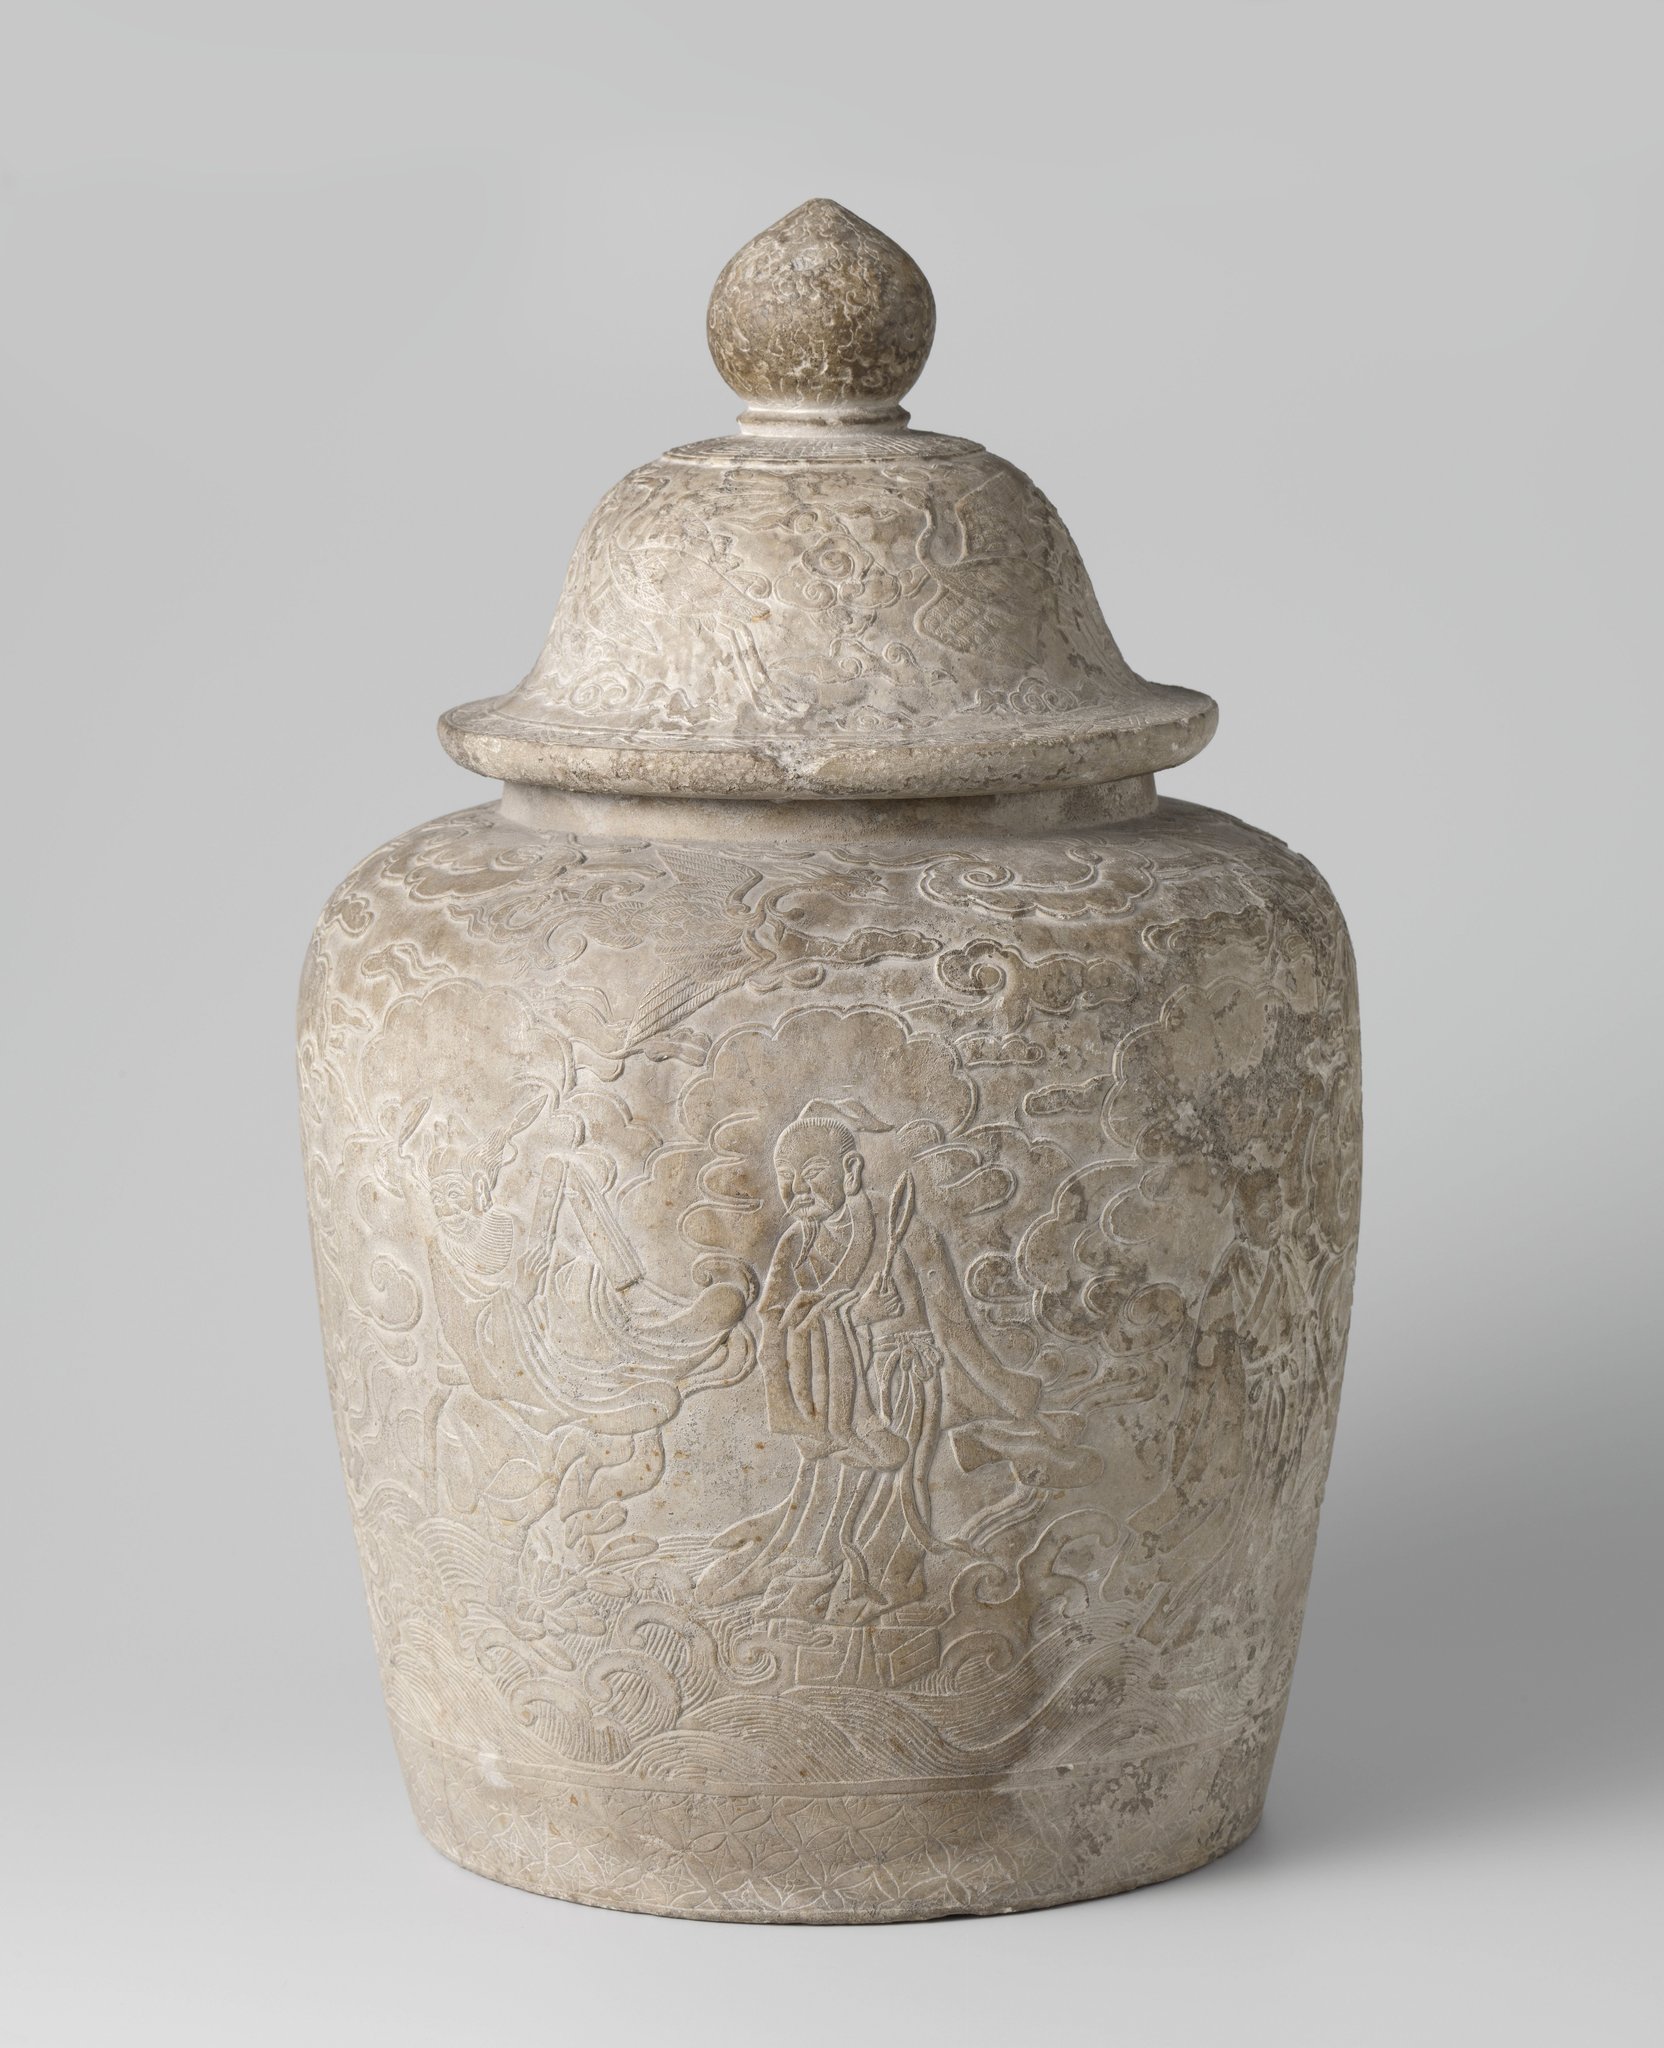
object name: vase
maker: Anonymous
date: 1500-1600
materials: limestone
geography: china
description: This exceptional and rare vase was once part of a set from the grave of a highly placed person. Daoist motifs are carved in relief on both the lid and the vase itself. The lid features flying cranes and clouds. Also depicted are the Eight Daoist Immortals crossing the sea. Together they symbolize happiness, good fortune, and eternal life.